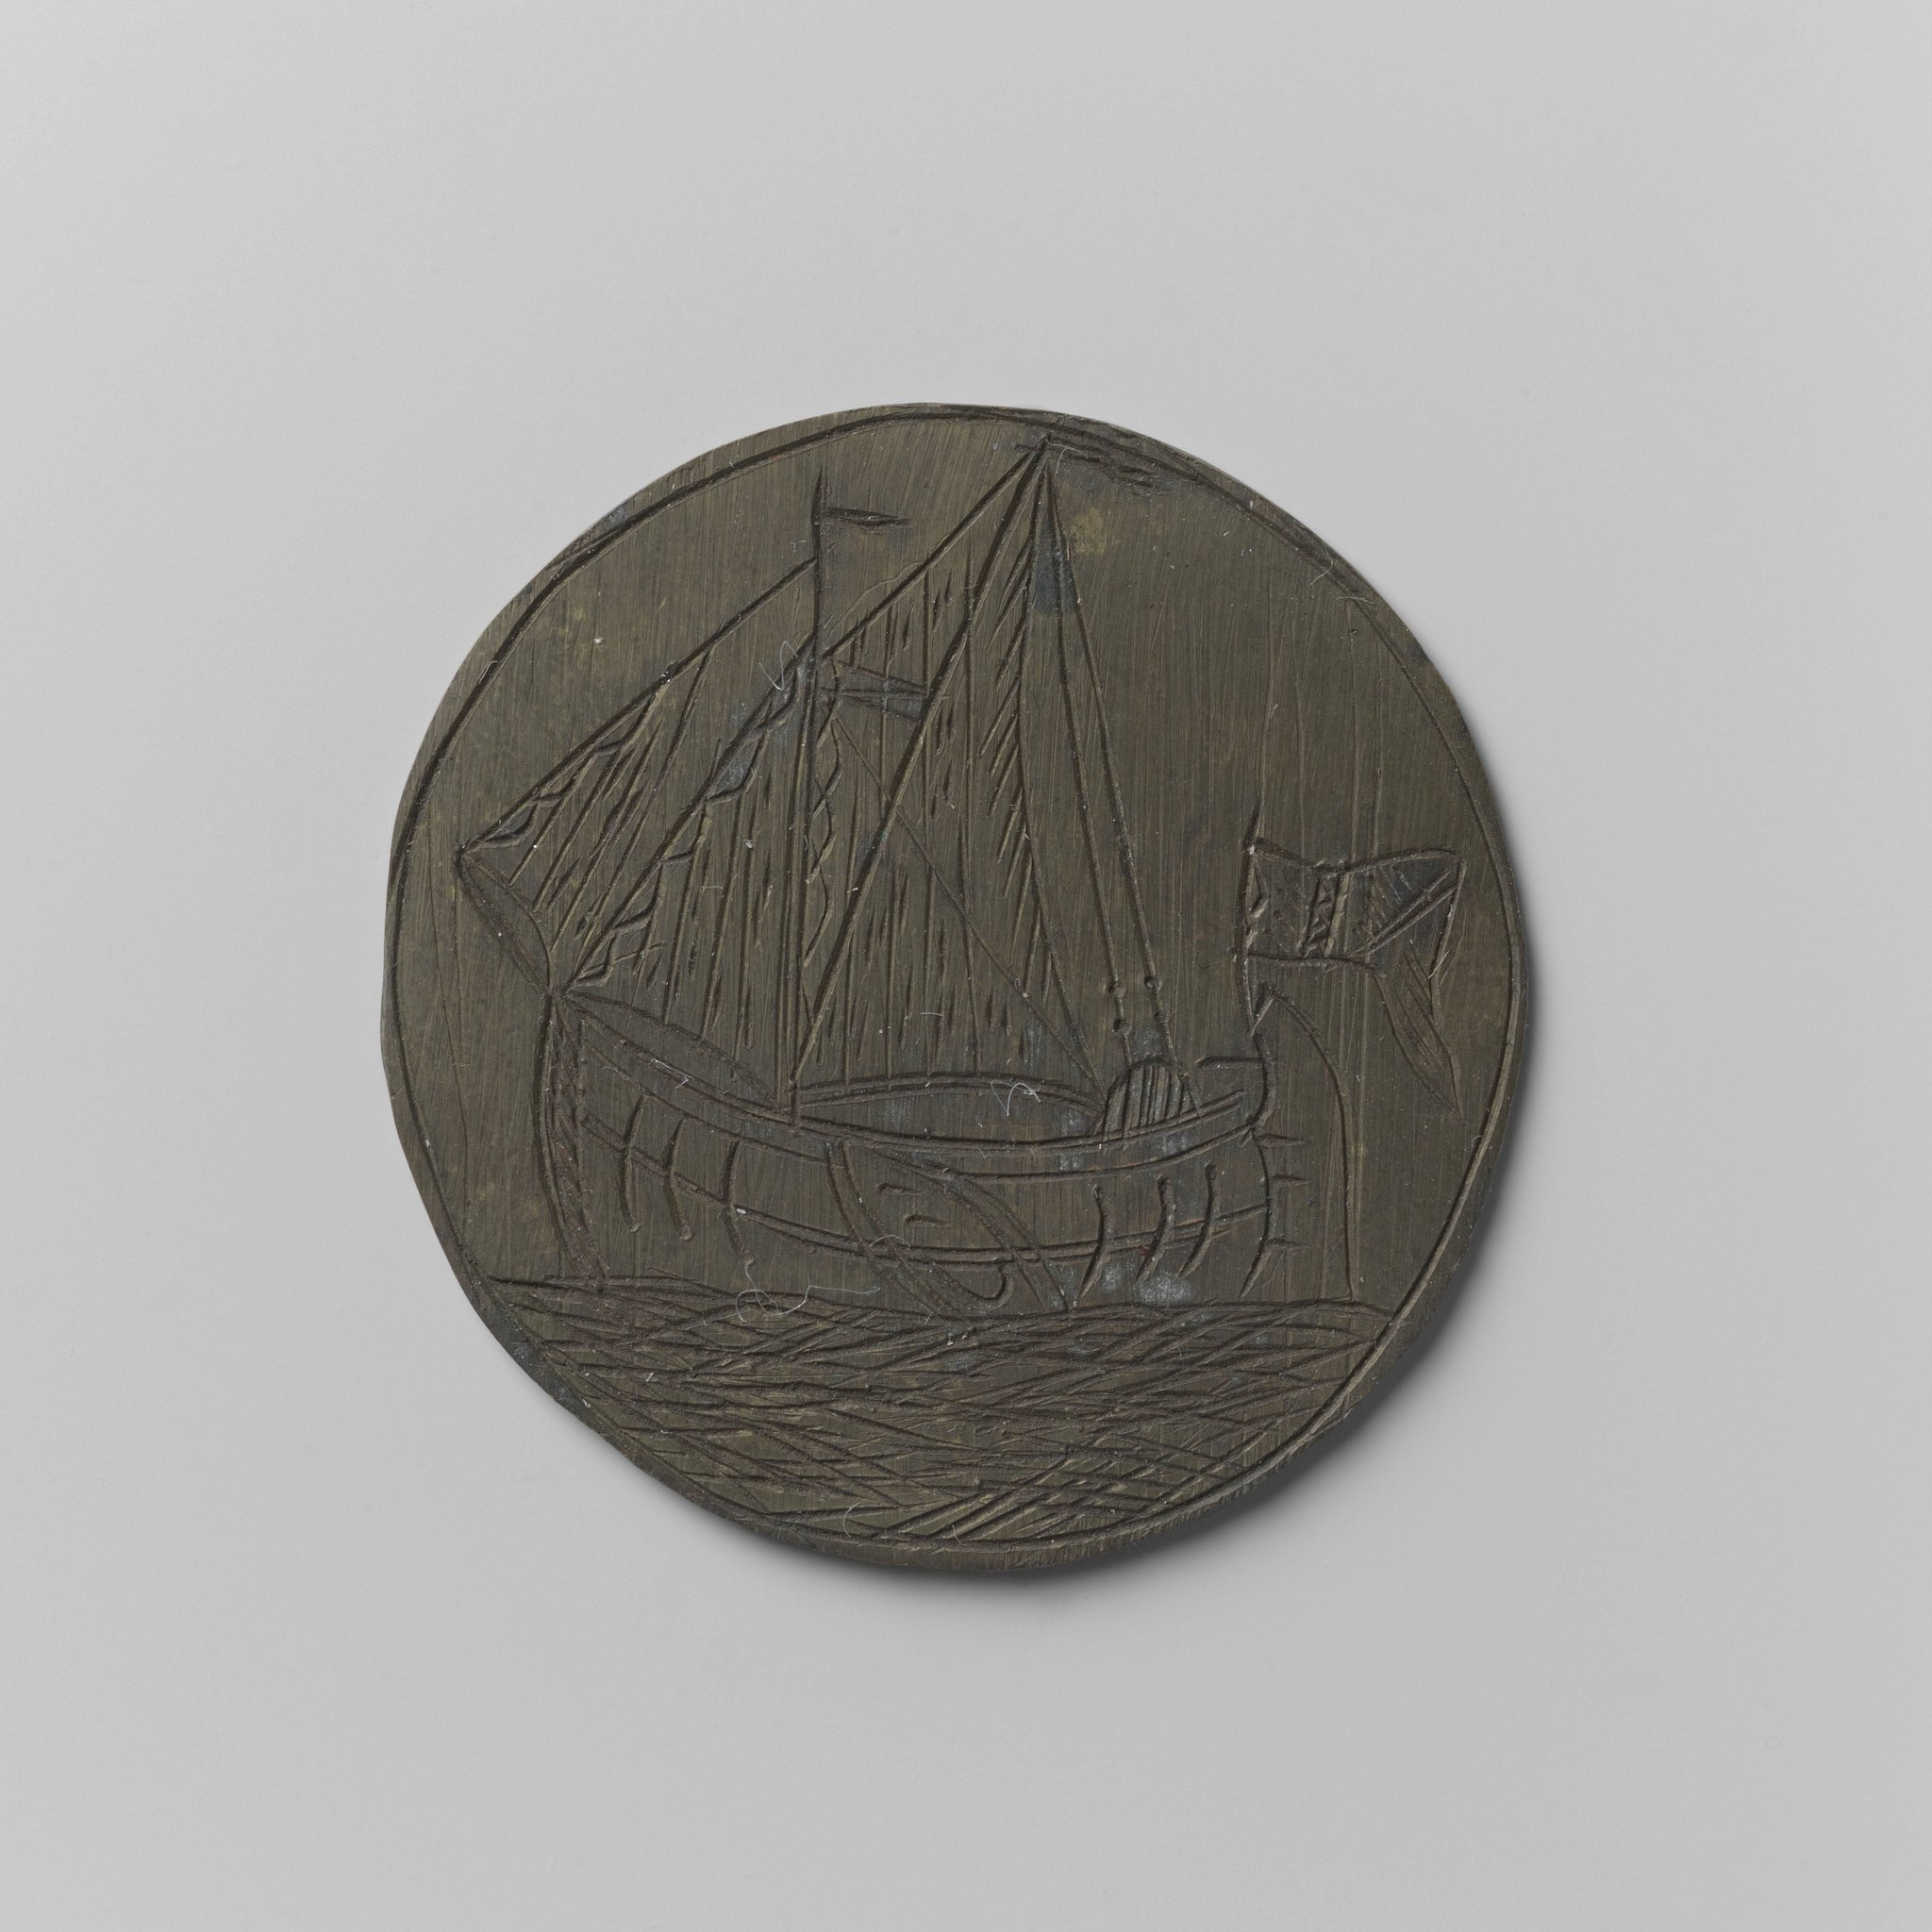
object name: medal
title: Klein binnenlandsvaardersgilde van Amsterdam, gildepenning van Tymen Schippers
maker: Anonymous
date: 1790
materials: brass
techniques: engraving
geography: amsterdam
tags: amsterdam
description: Messing penning. Voorzijde: naar links varend schip; op achterplecht:vlag met wapenschild. Keerzijde: opschrift